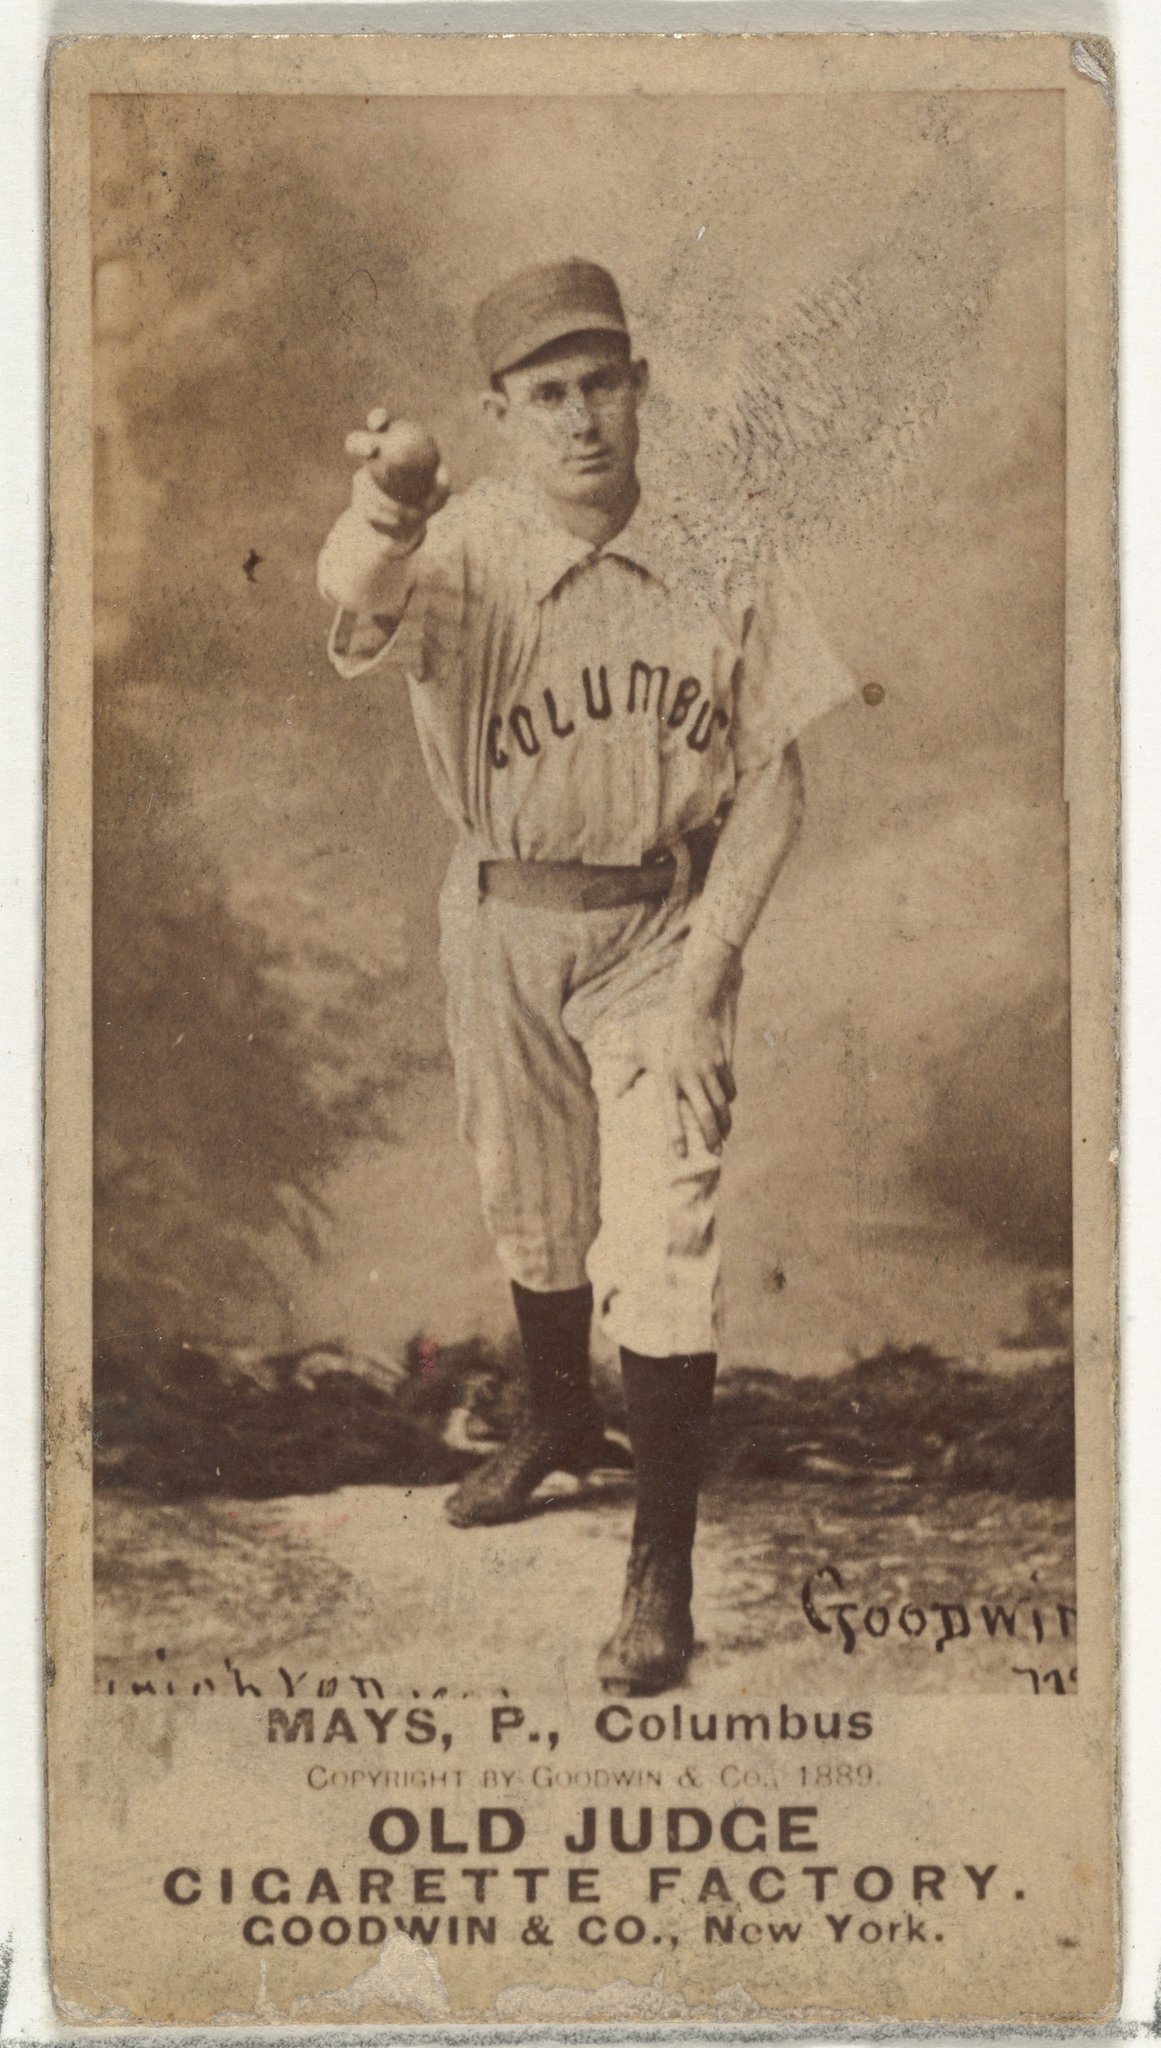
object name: baseball card, photograph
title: Albert C. "Al" Mays, Pitcher, Cleveland, from the Old Judge series (N172) for Old Judge Cigarettes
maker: goodwin & company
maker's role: publisher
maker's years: 1850-1950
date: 1889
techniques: albumen silver print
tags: men,portraits,baseball,athletes